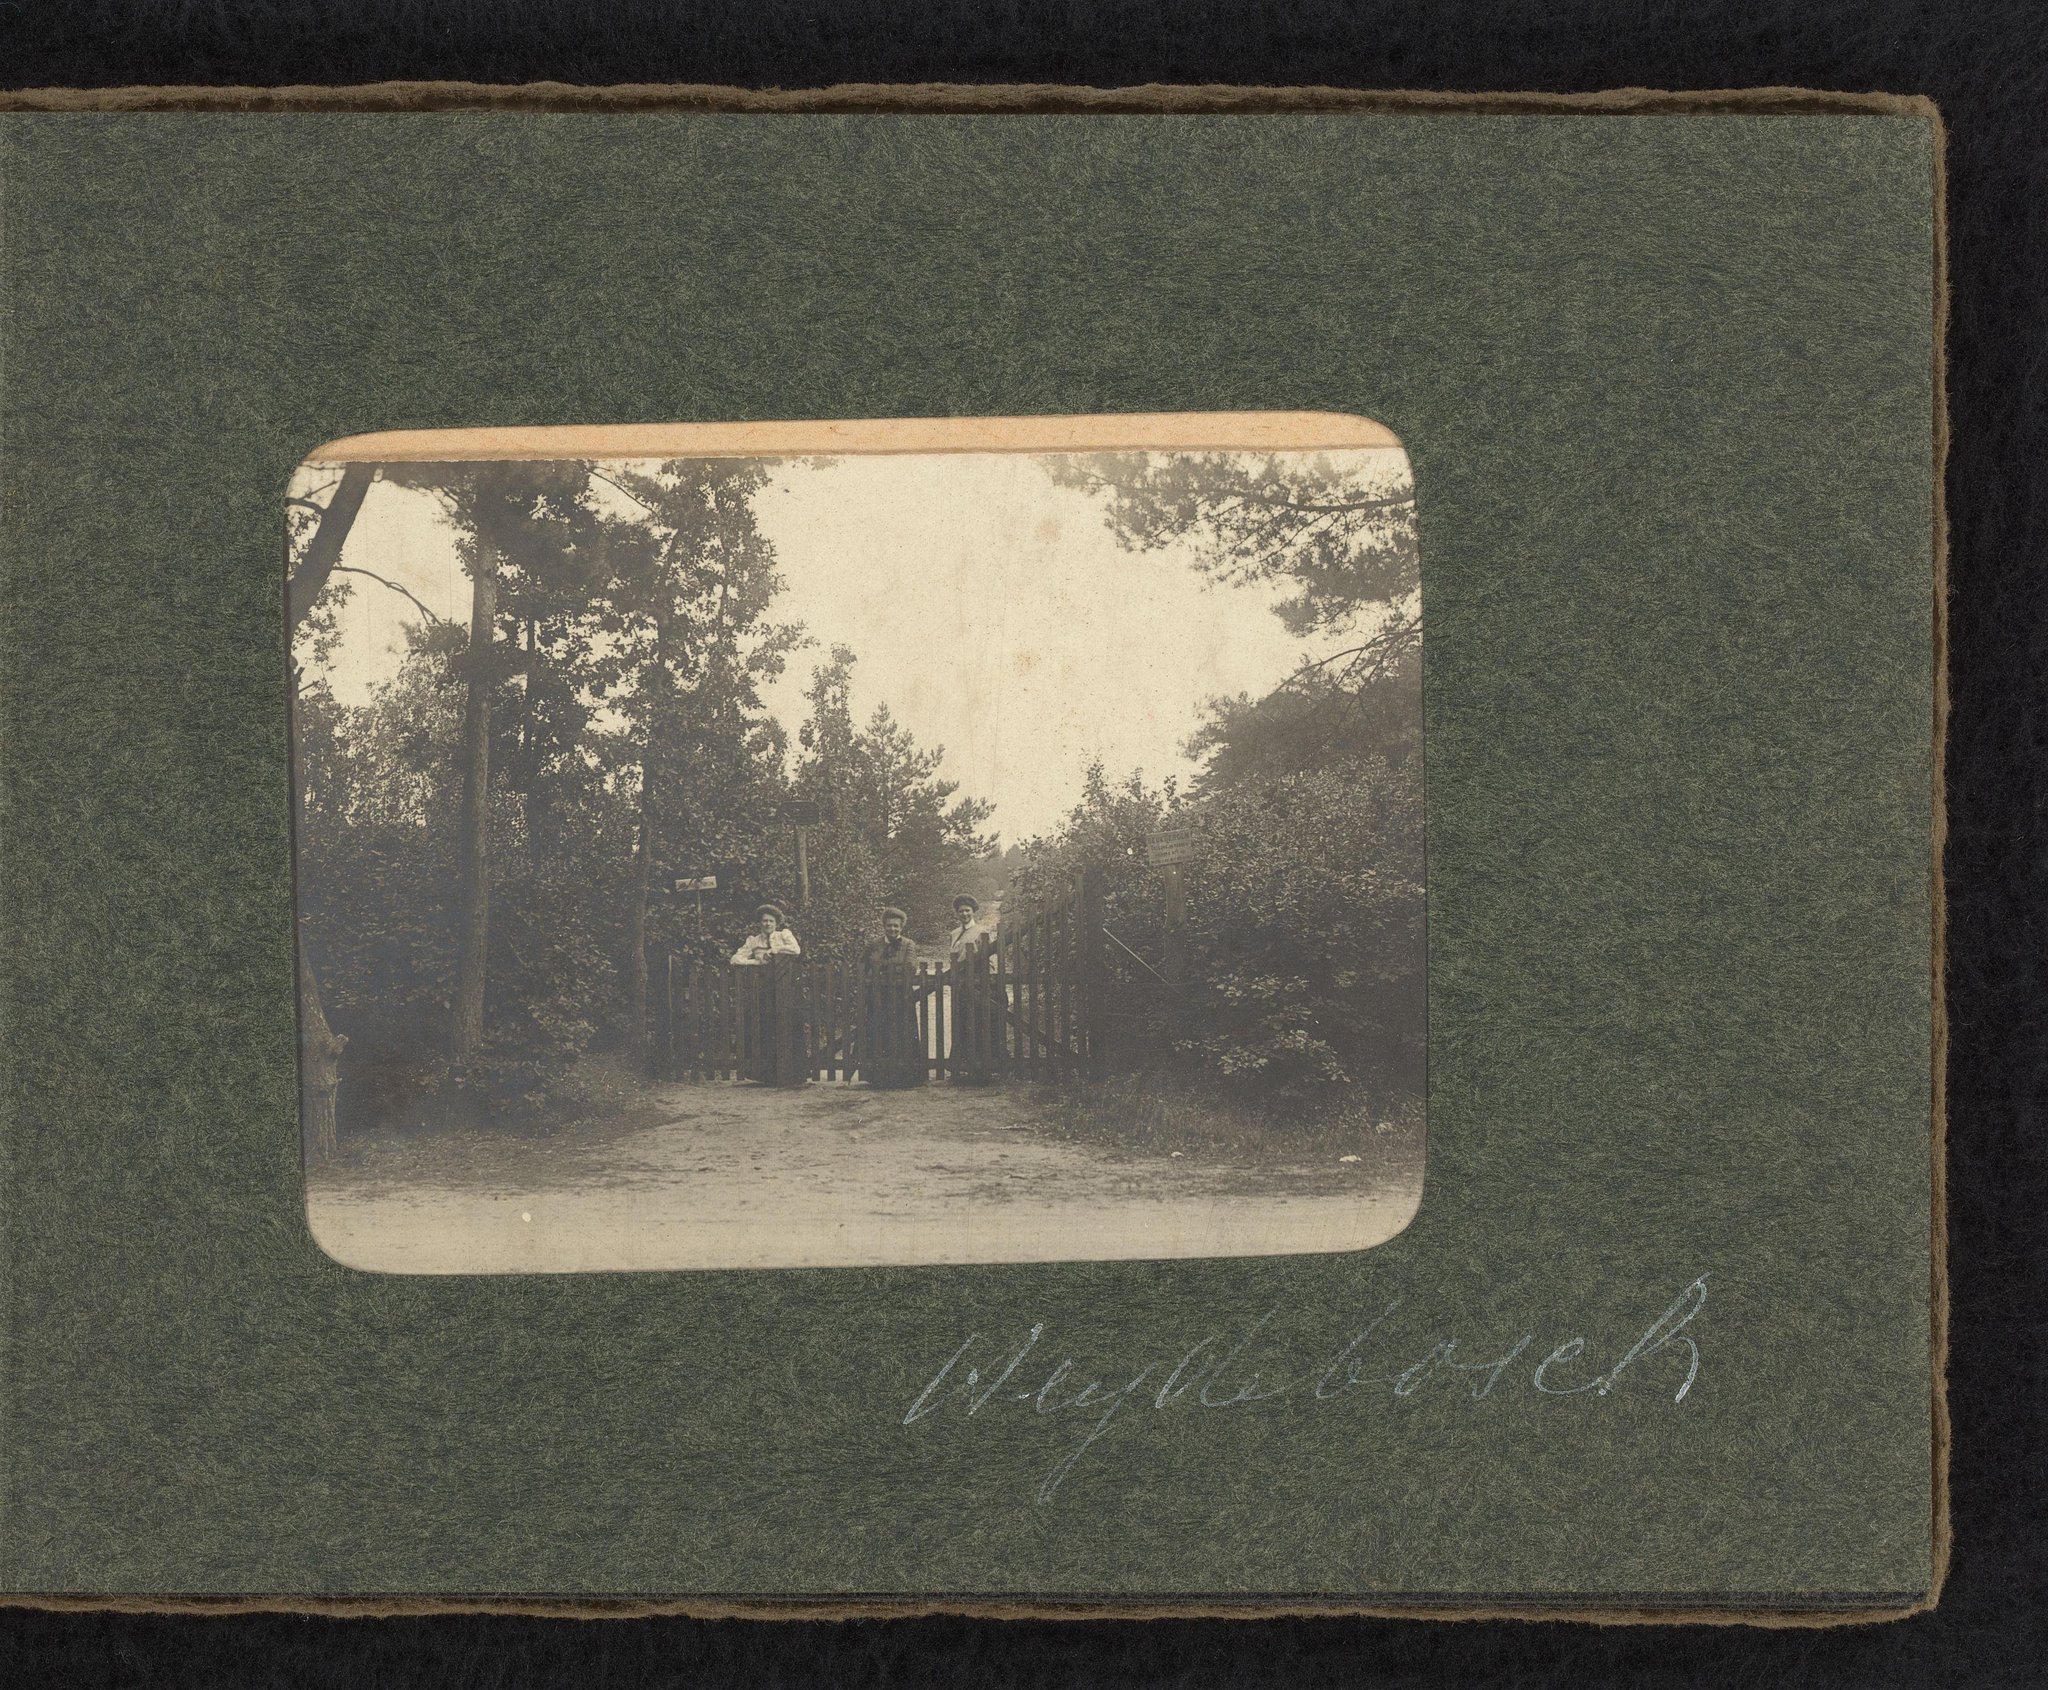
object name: album leaf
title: Drie vrouwen voor het toegangshek van landgoed Beukbergen in Huis ter Heide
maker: hendrik herman van den berg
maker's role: amateurfotograaf, jurist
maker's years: 1875-1944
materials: paper, cardboard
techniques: gelatin silver print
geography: huis ter heide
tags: adult woman, gate, entrance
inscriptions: inscription: ‘Heydebosch’